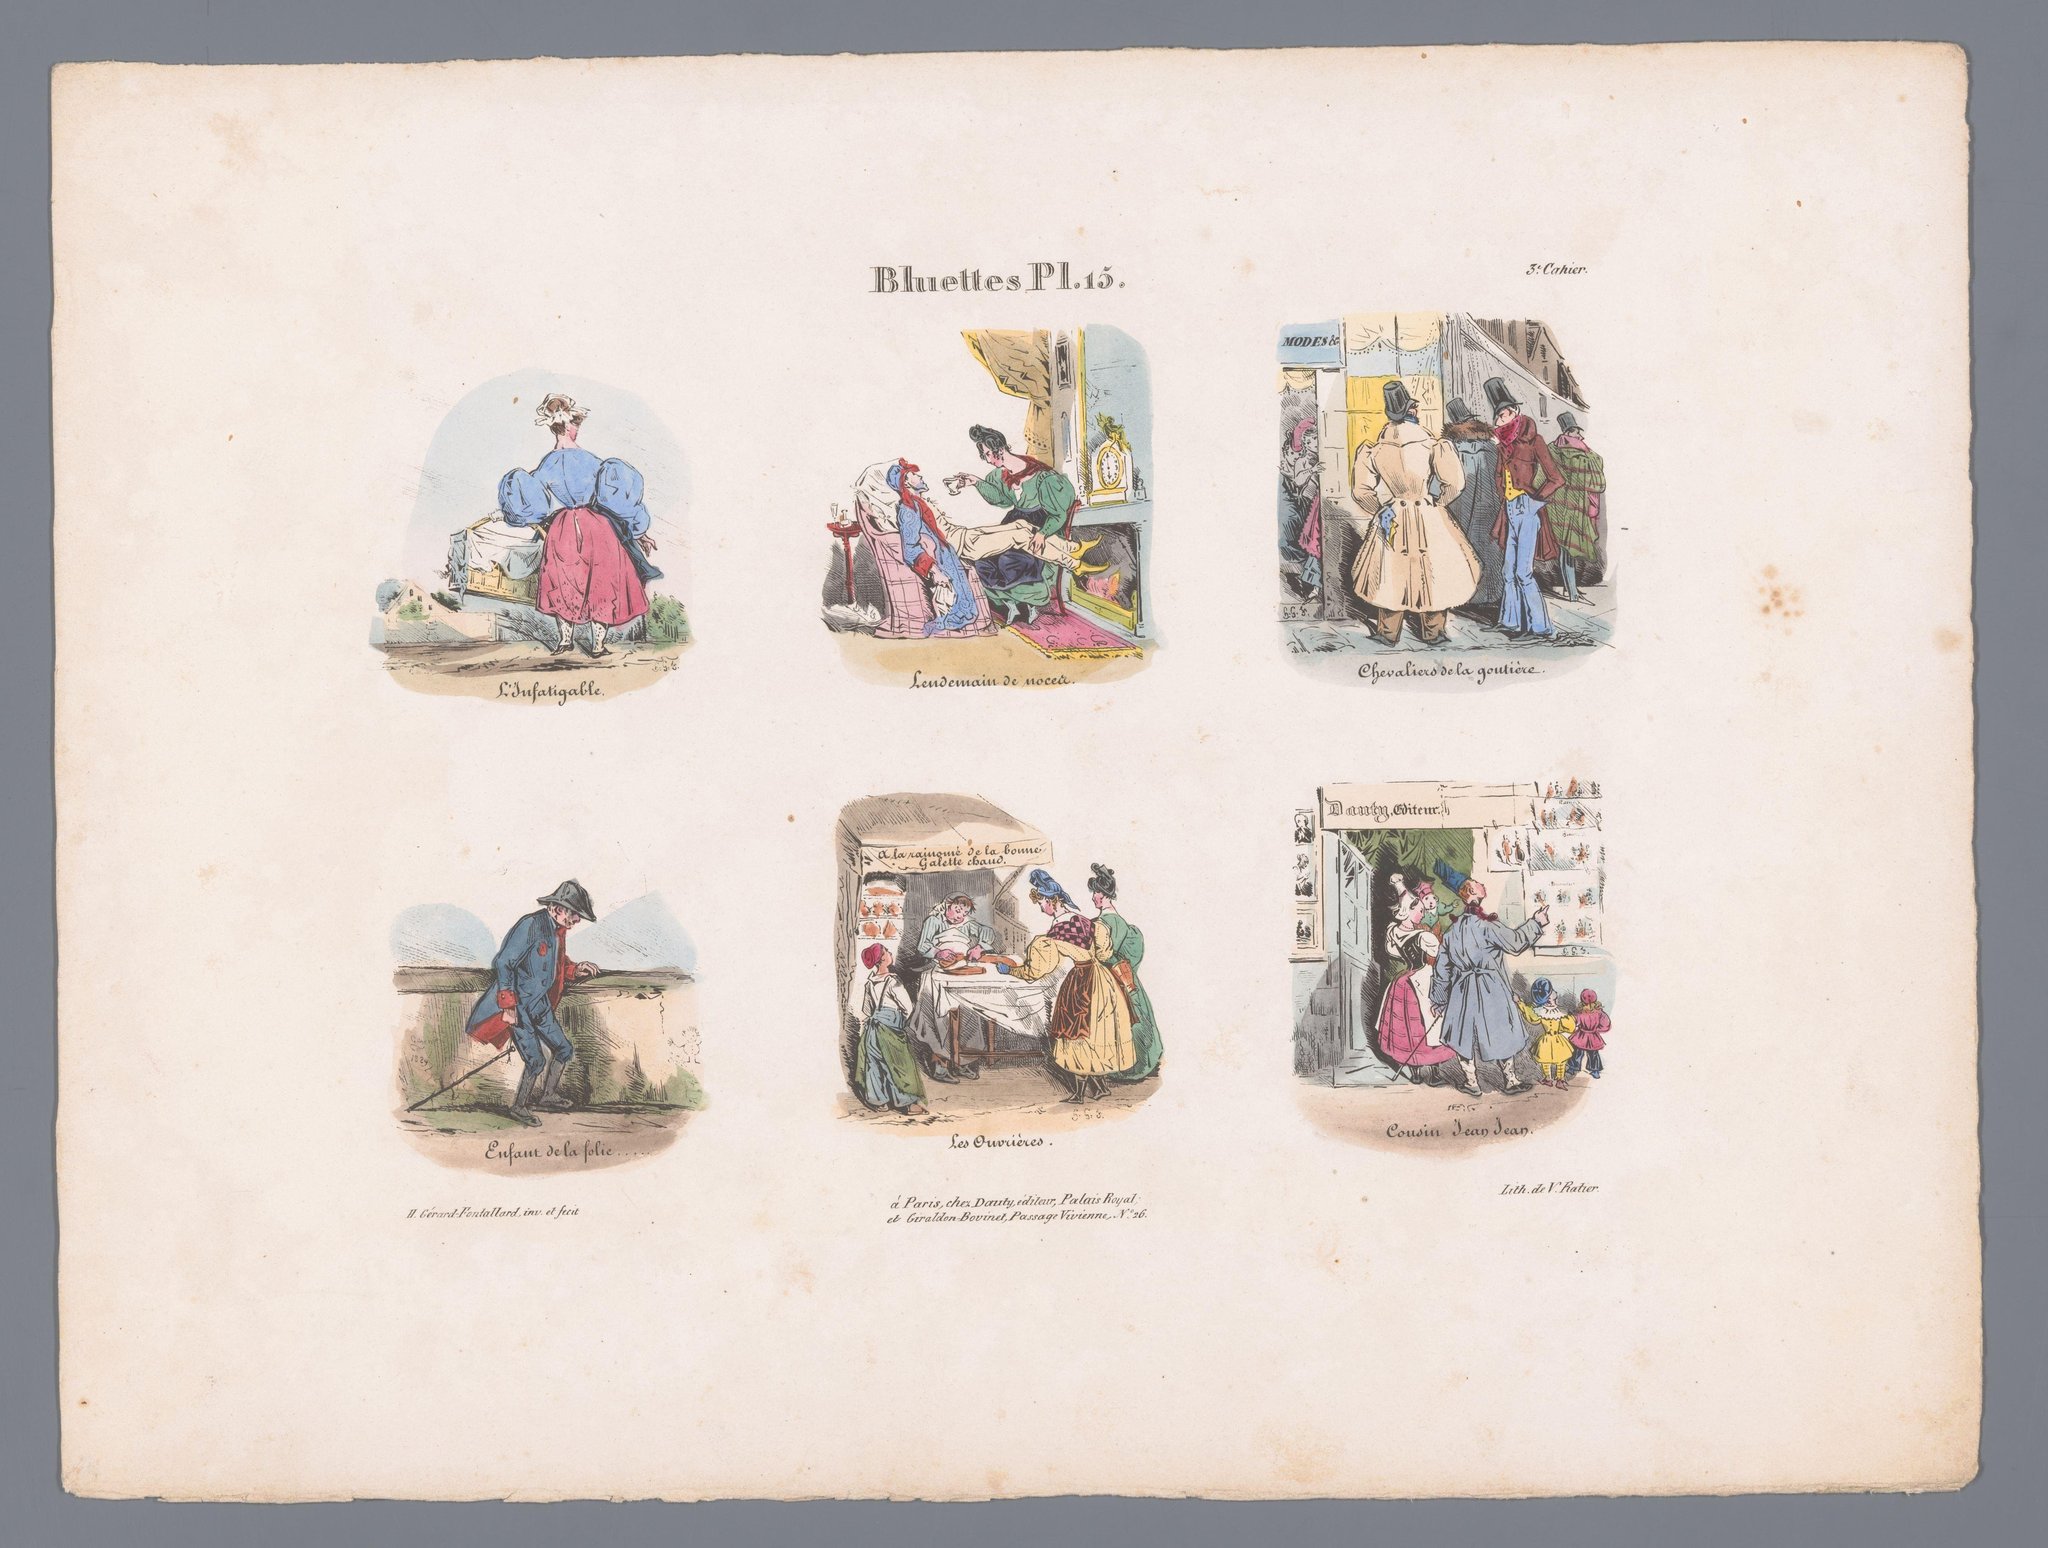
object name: print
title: Bluettes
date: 1829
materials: paper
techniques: hand coloring, lithograph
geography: paris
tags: various human types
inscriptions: collector's mark: Lugt 2228a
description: Prent maakt deel uit van een omslag met achttien prenten.